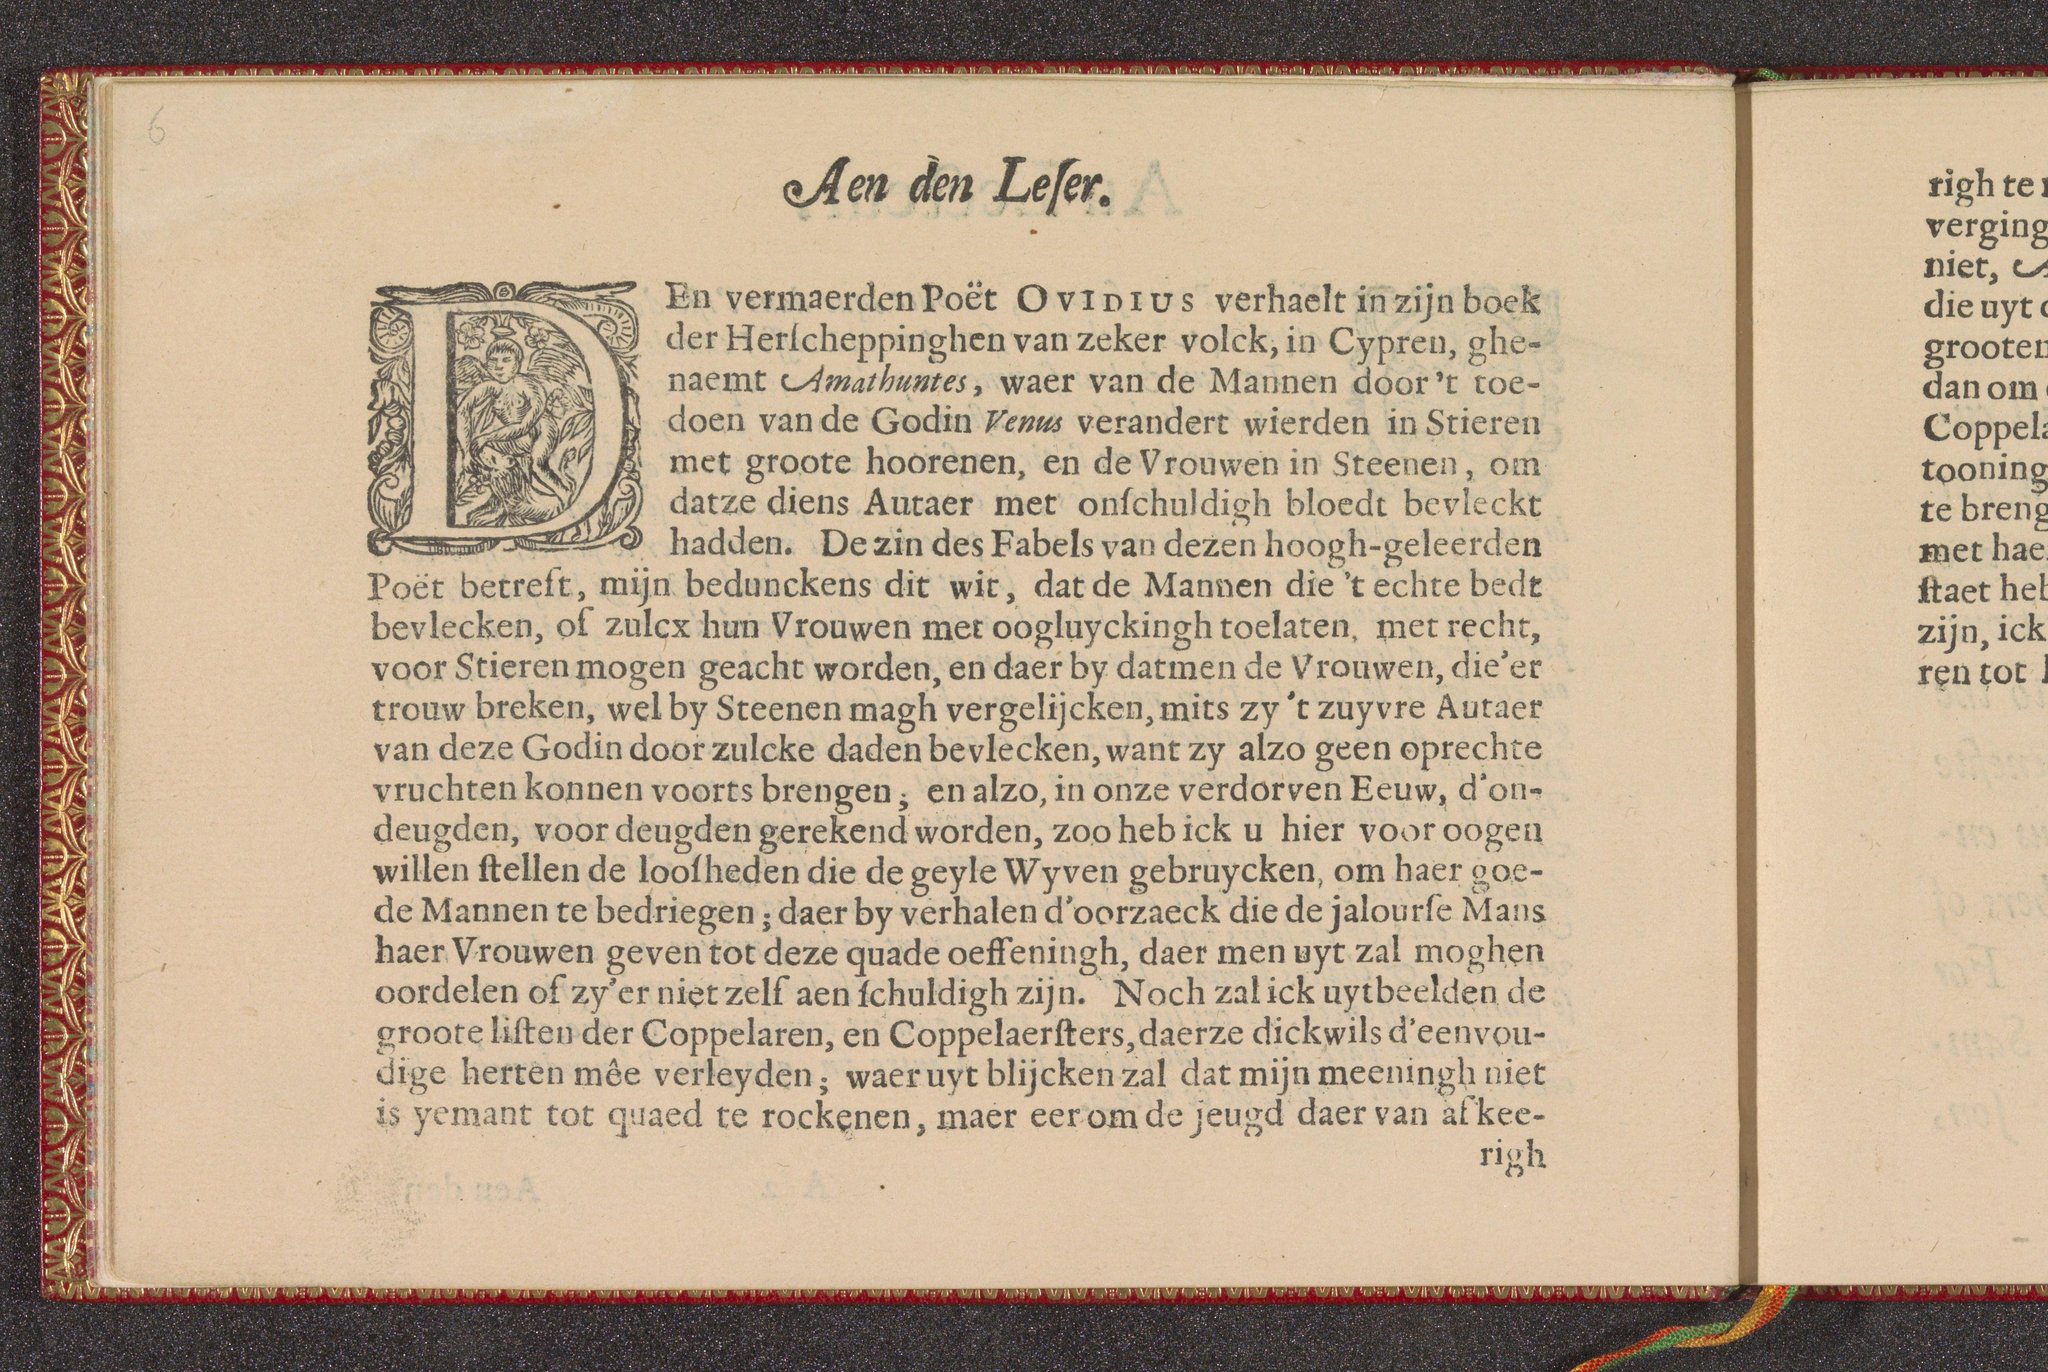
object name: album leaf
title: Nederlandstalig voorwoord, pagina 1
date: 1641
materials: paper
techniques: letterpress printing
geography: amsterdam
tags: initial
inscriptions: date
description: Nederlandstalig voorwoord op twee pagina's: pagina 1. Met de aanhef: Aen den leser. De tekst vangt aan met een gedecoreerde initiaal D. Het blad maakt deel uit van een album.